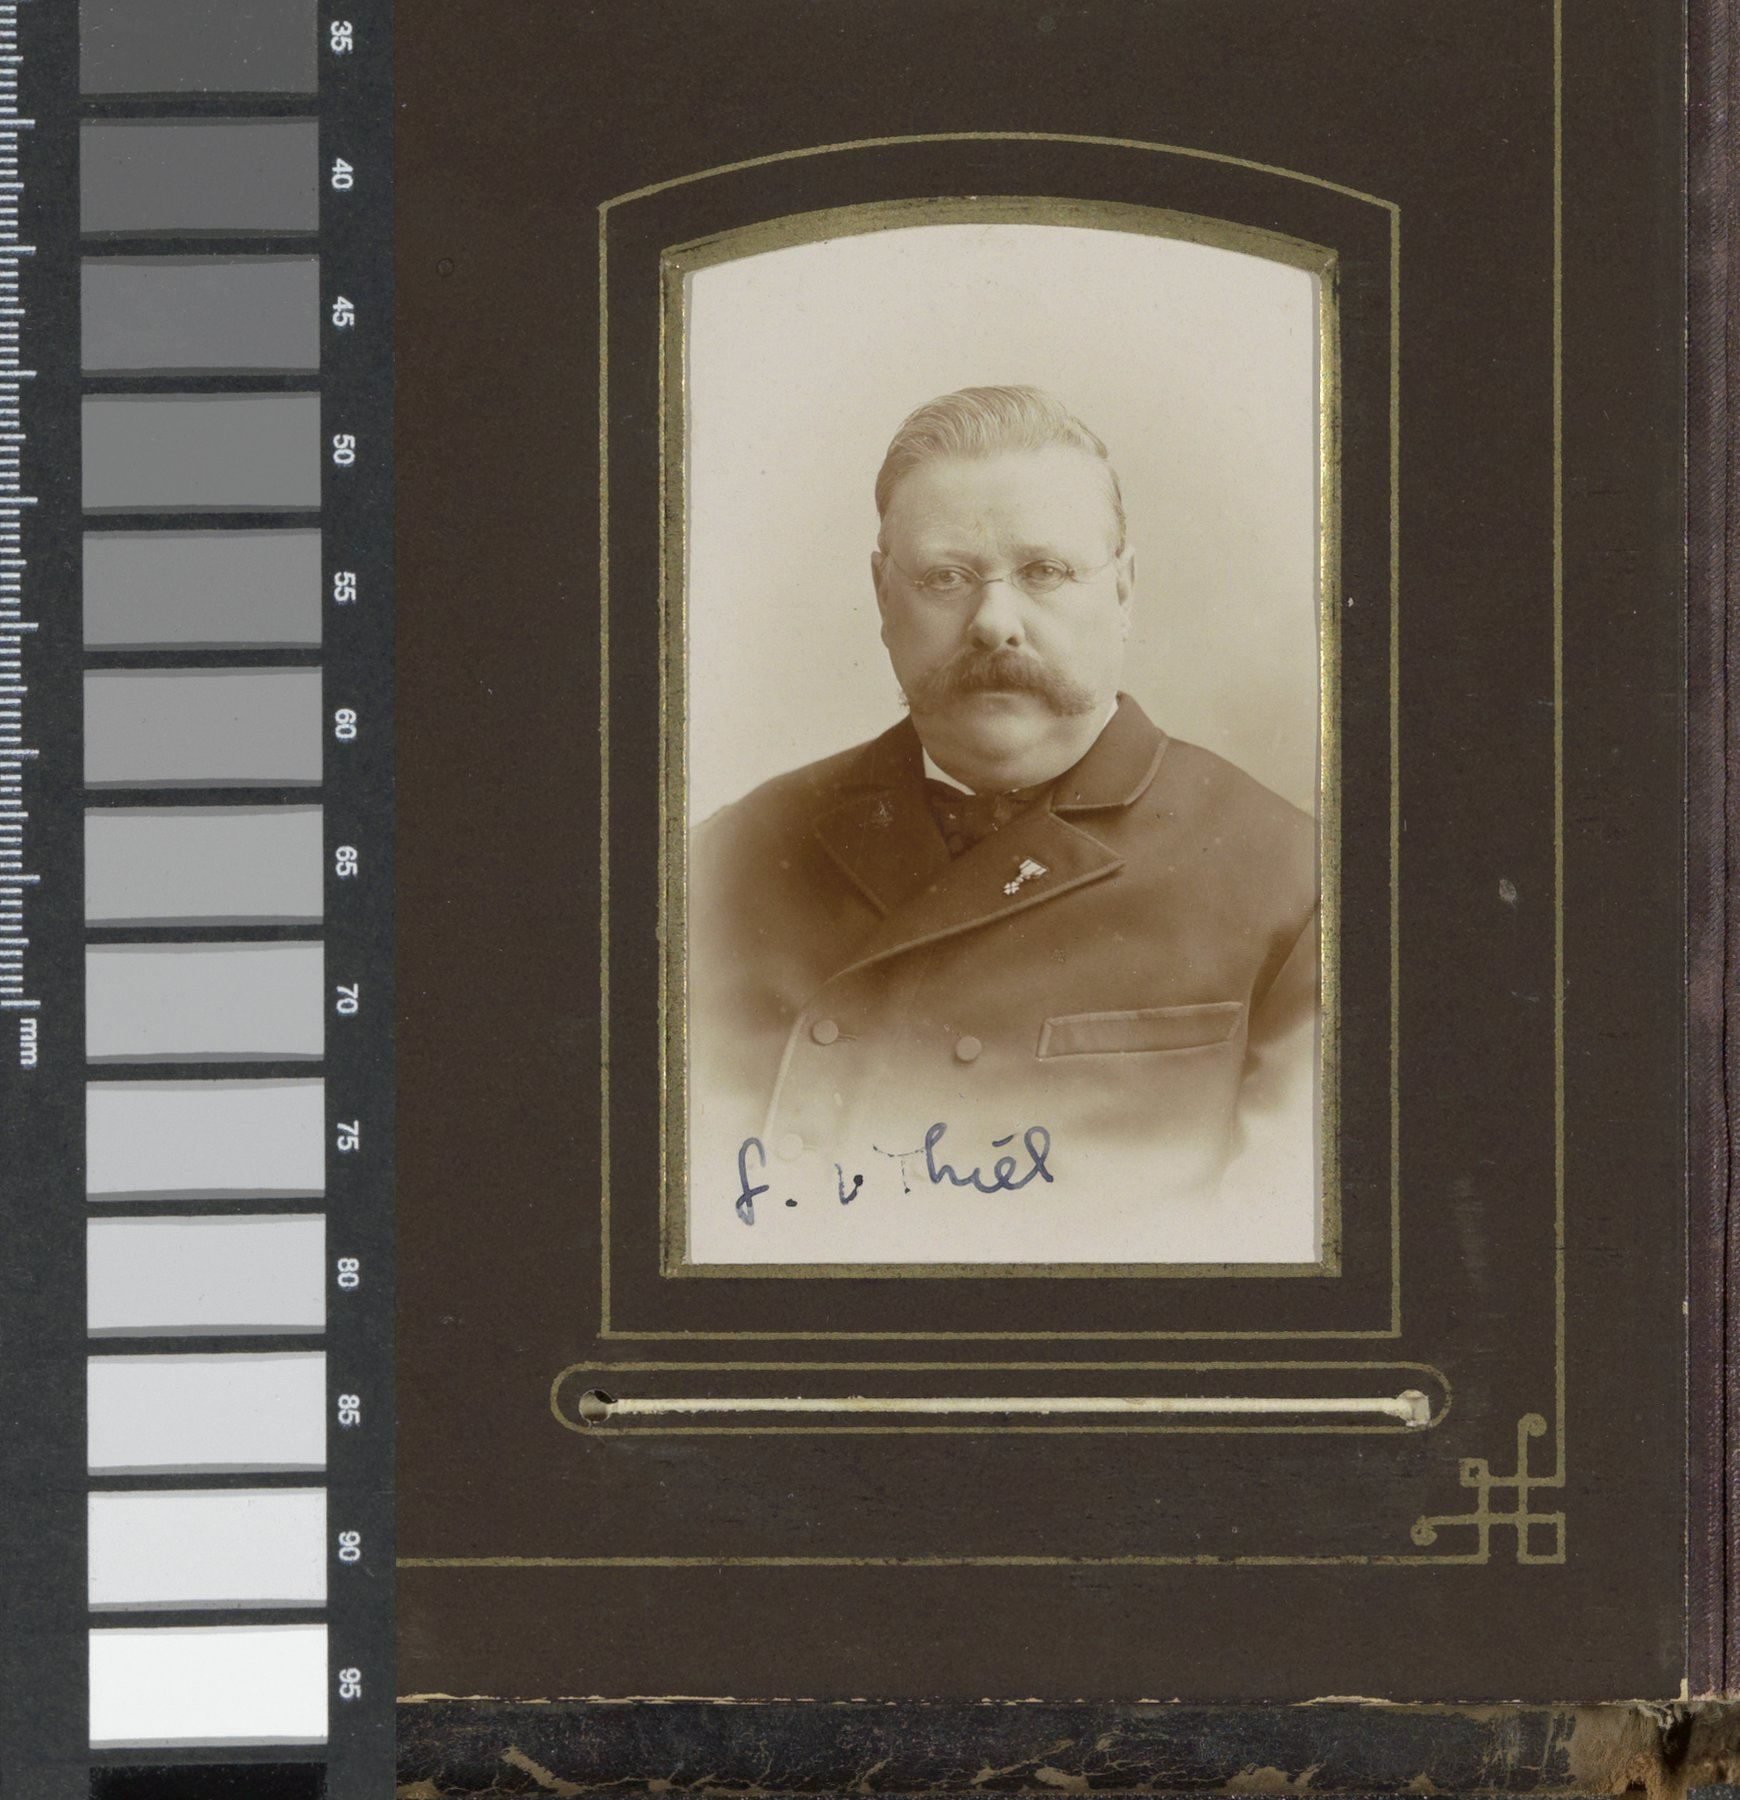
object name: photograph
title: Portret van Luitenant-kolonel J.G. van Thiel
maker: adolphe zimmermans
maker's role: fotograaf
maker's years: 1858-1922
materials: cardboard, paper, photographic support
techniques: collodion silver print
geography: the hague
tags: eyeglasses, spectacles, adult man, historical persons, the hague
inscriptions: address: ‘de Riemerstraat [...] La Haye.’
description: Onderdeel van Fotoalbum van de families Matthes, Doorman en Van Thiel.